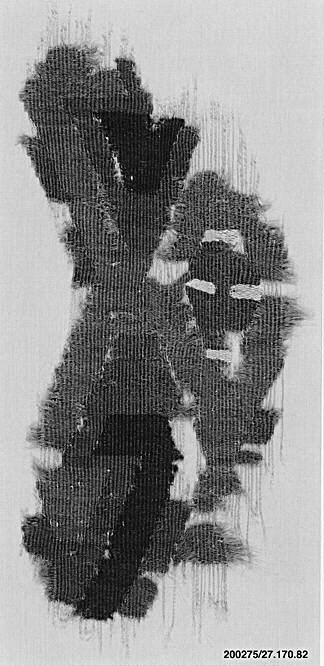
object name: textile fragment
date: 901-1100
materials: wool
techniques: weave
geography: egypt